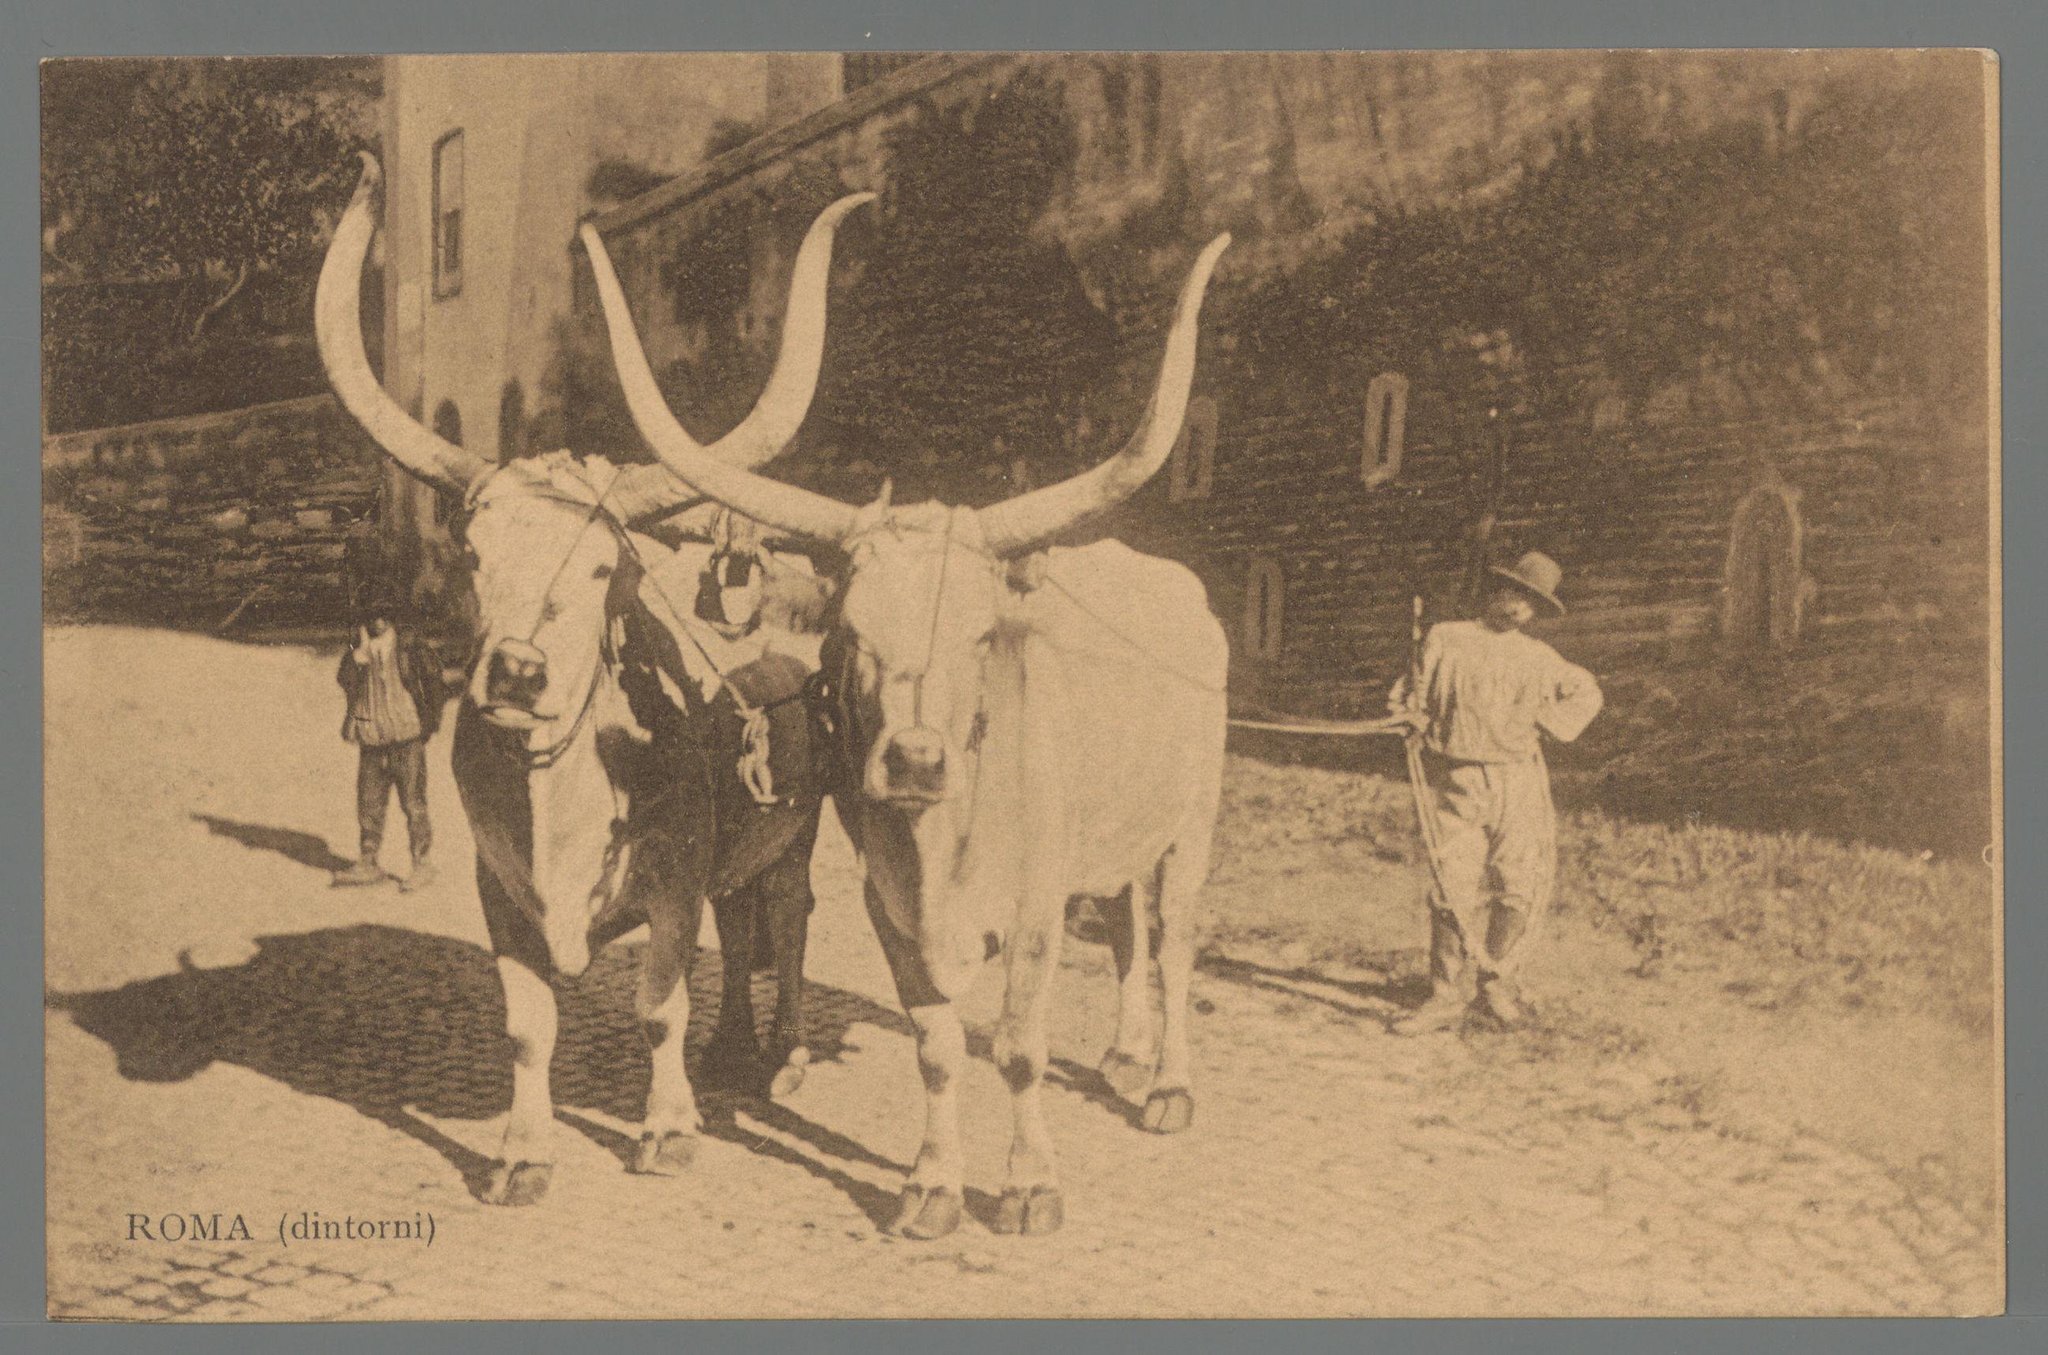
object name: photomechanical print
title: Roma (dintorni)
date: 1906-1920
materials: cardboard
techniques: photograph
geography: italy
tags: ox (+ labourers ~ crafts, industries, agriculture), rome